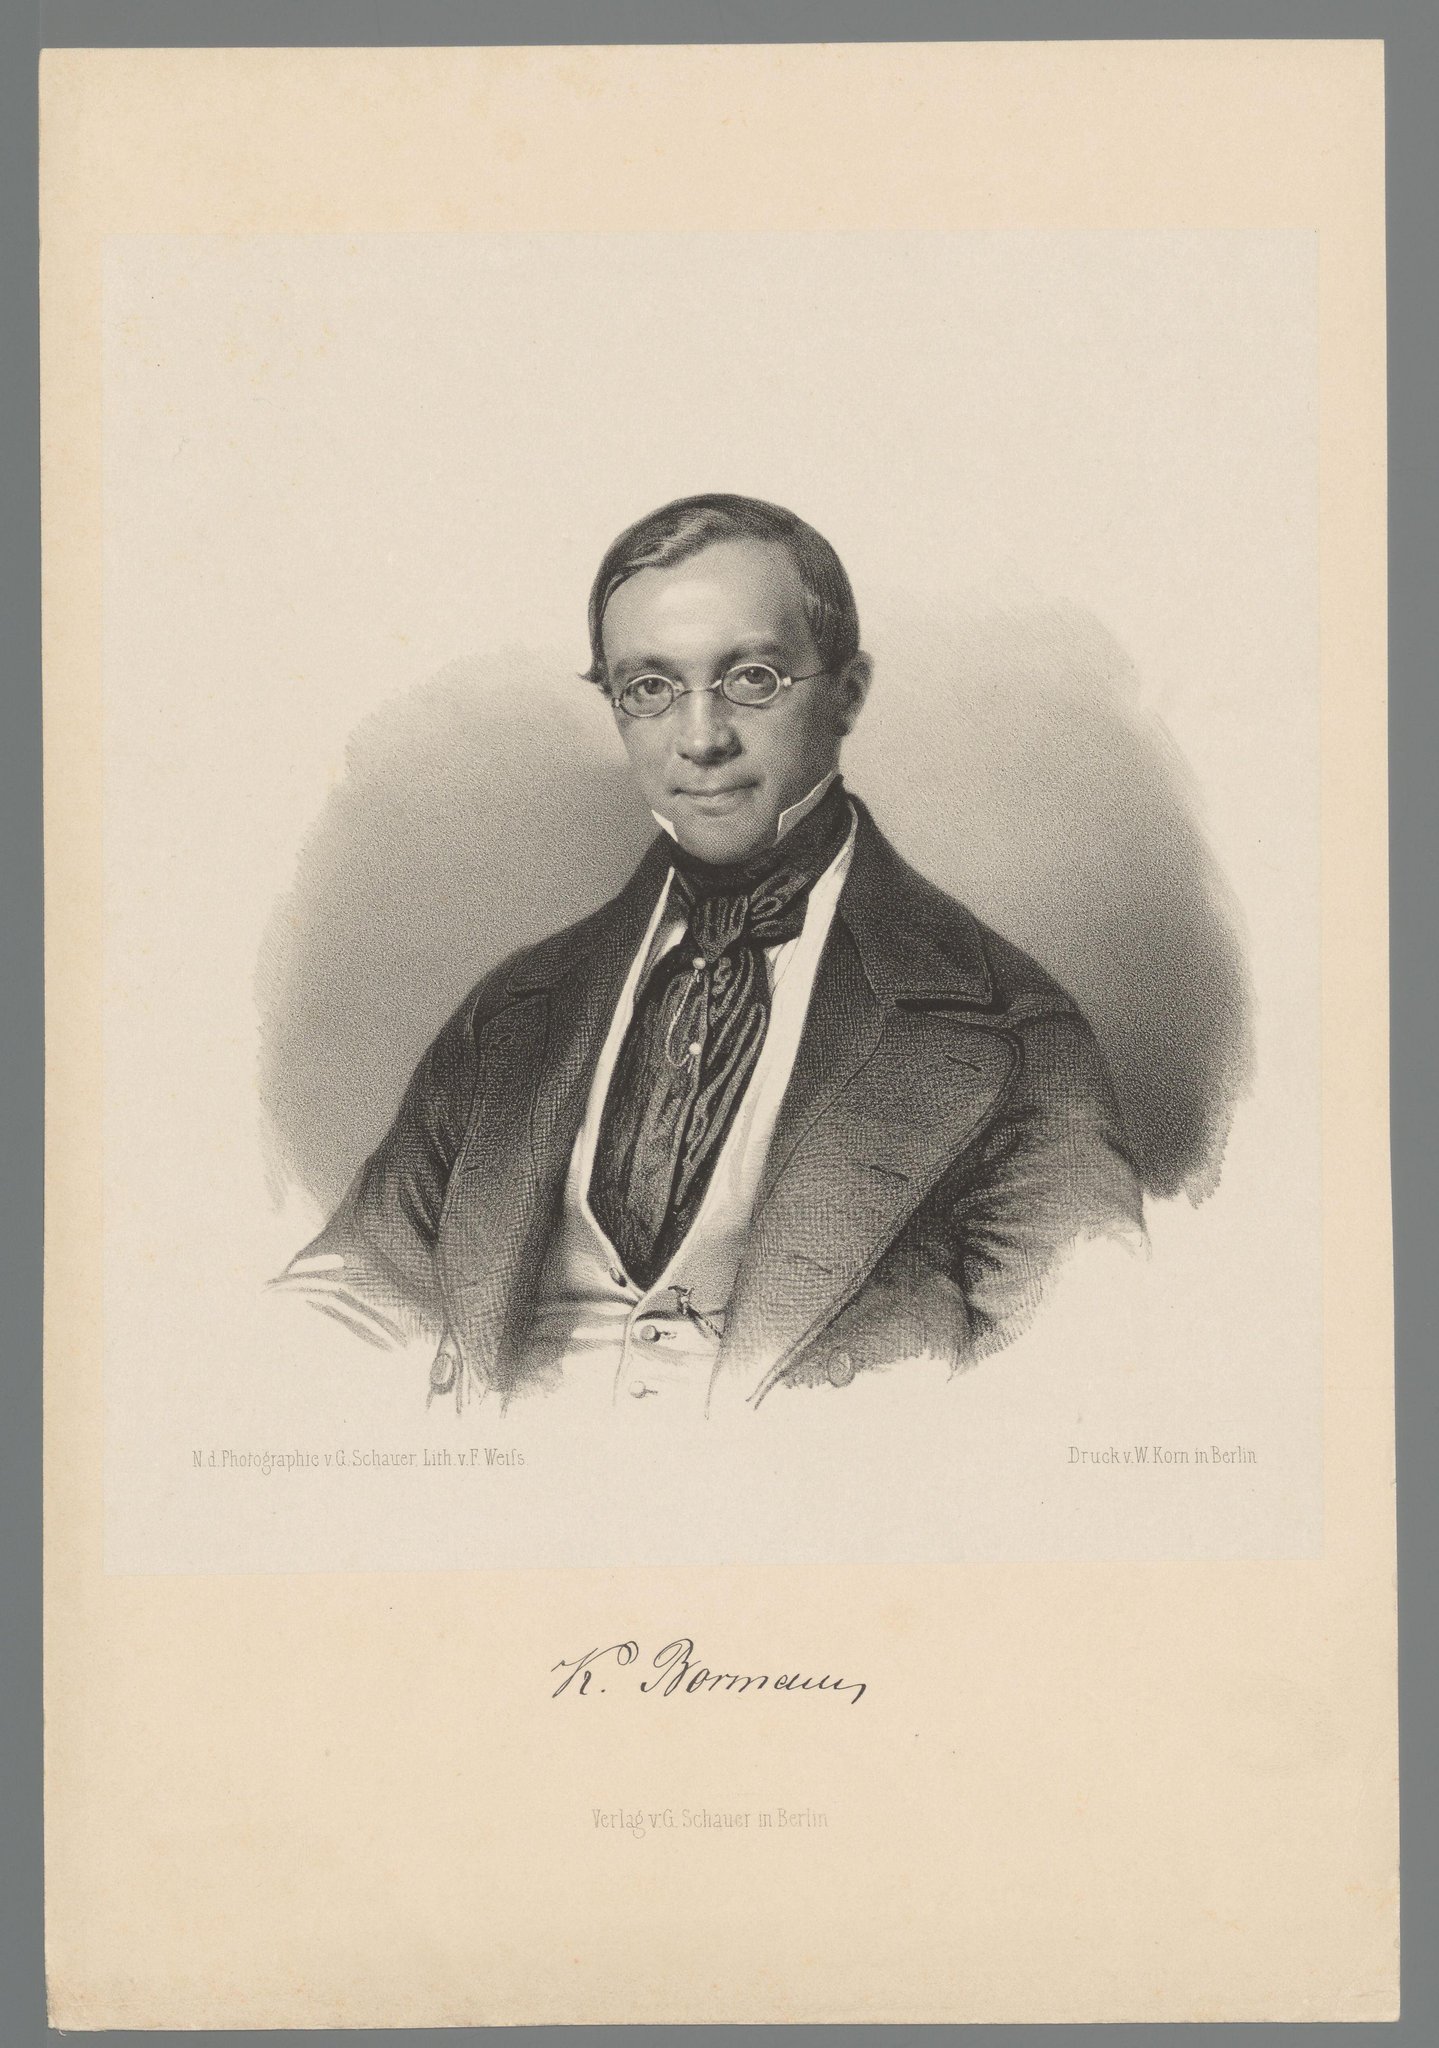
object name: print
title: Portret van K. Bormann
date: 1851-1870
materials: paper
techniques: lithograph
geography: berlin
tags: eyeglasses, spectacles, adult man, historical persons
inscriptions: collector's mark: Lugt 2228